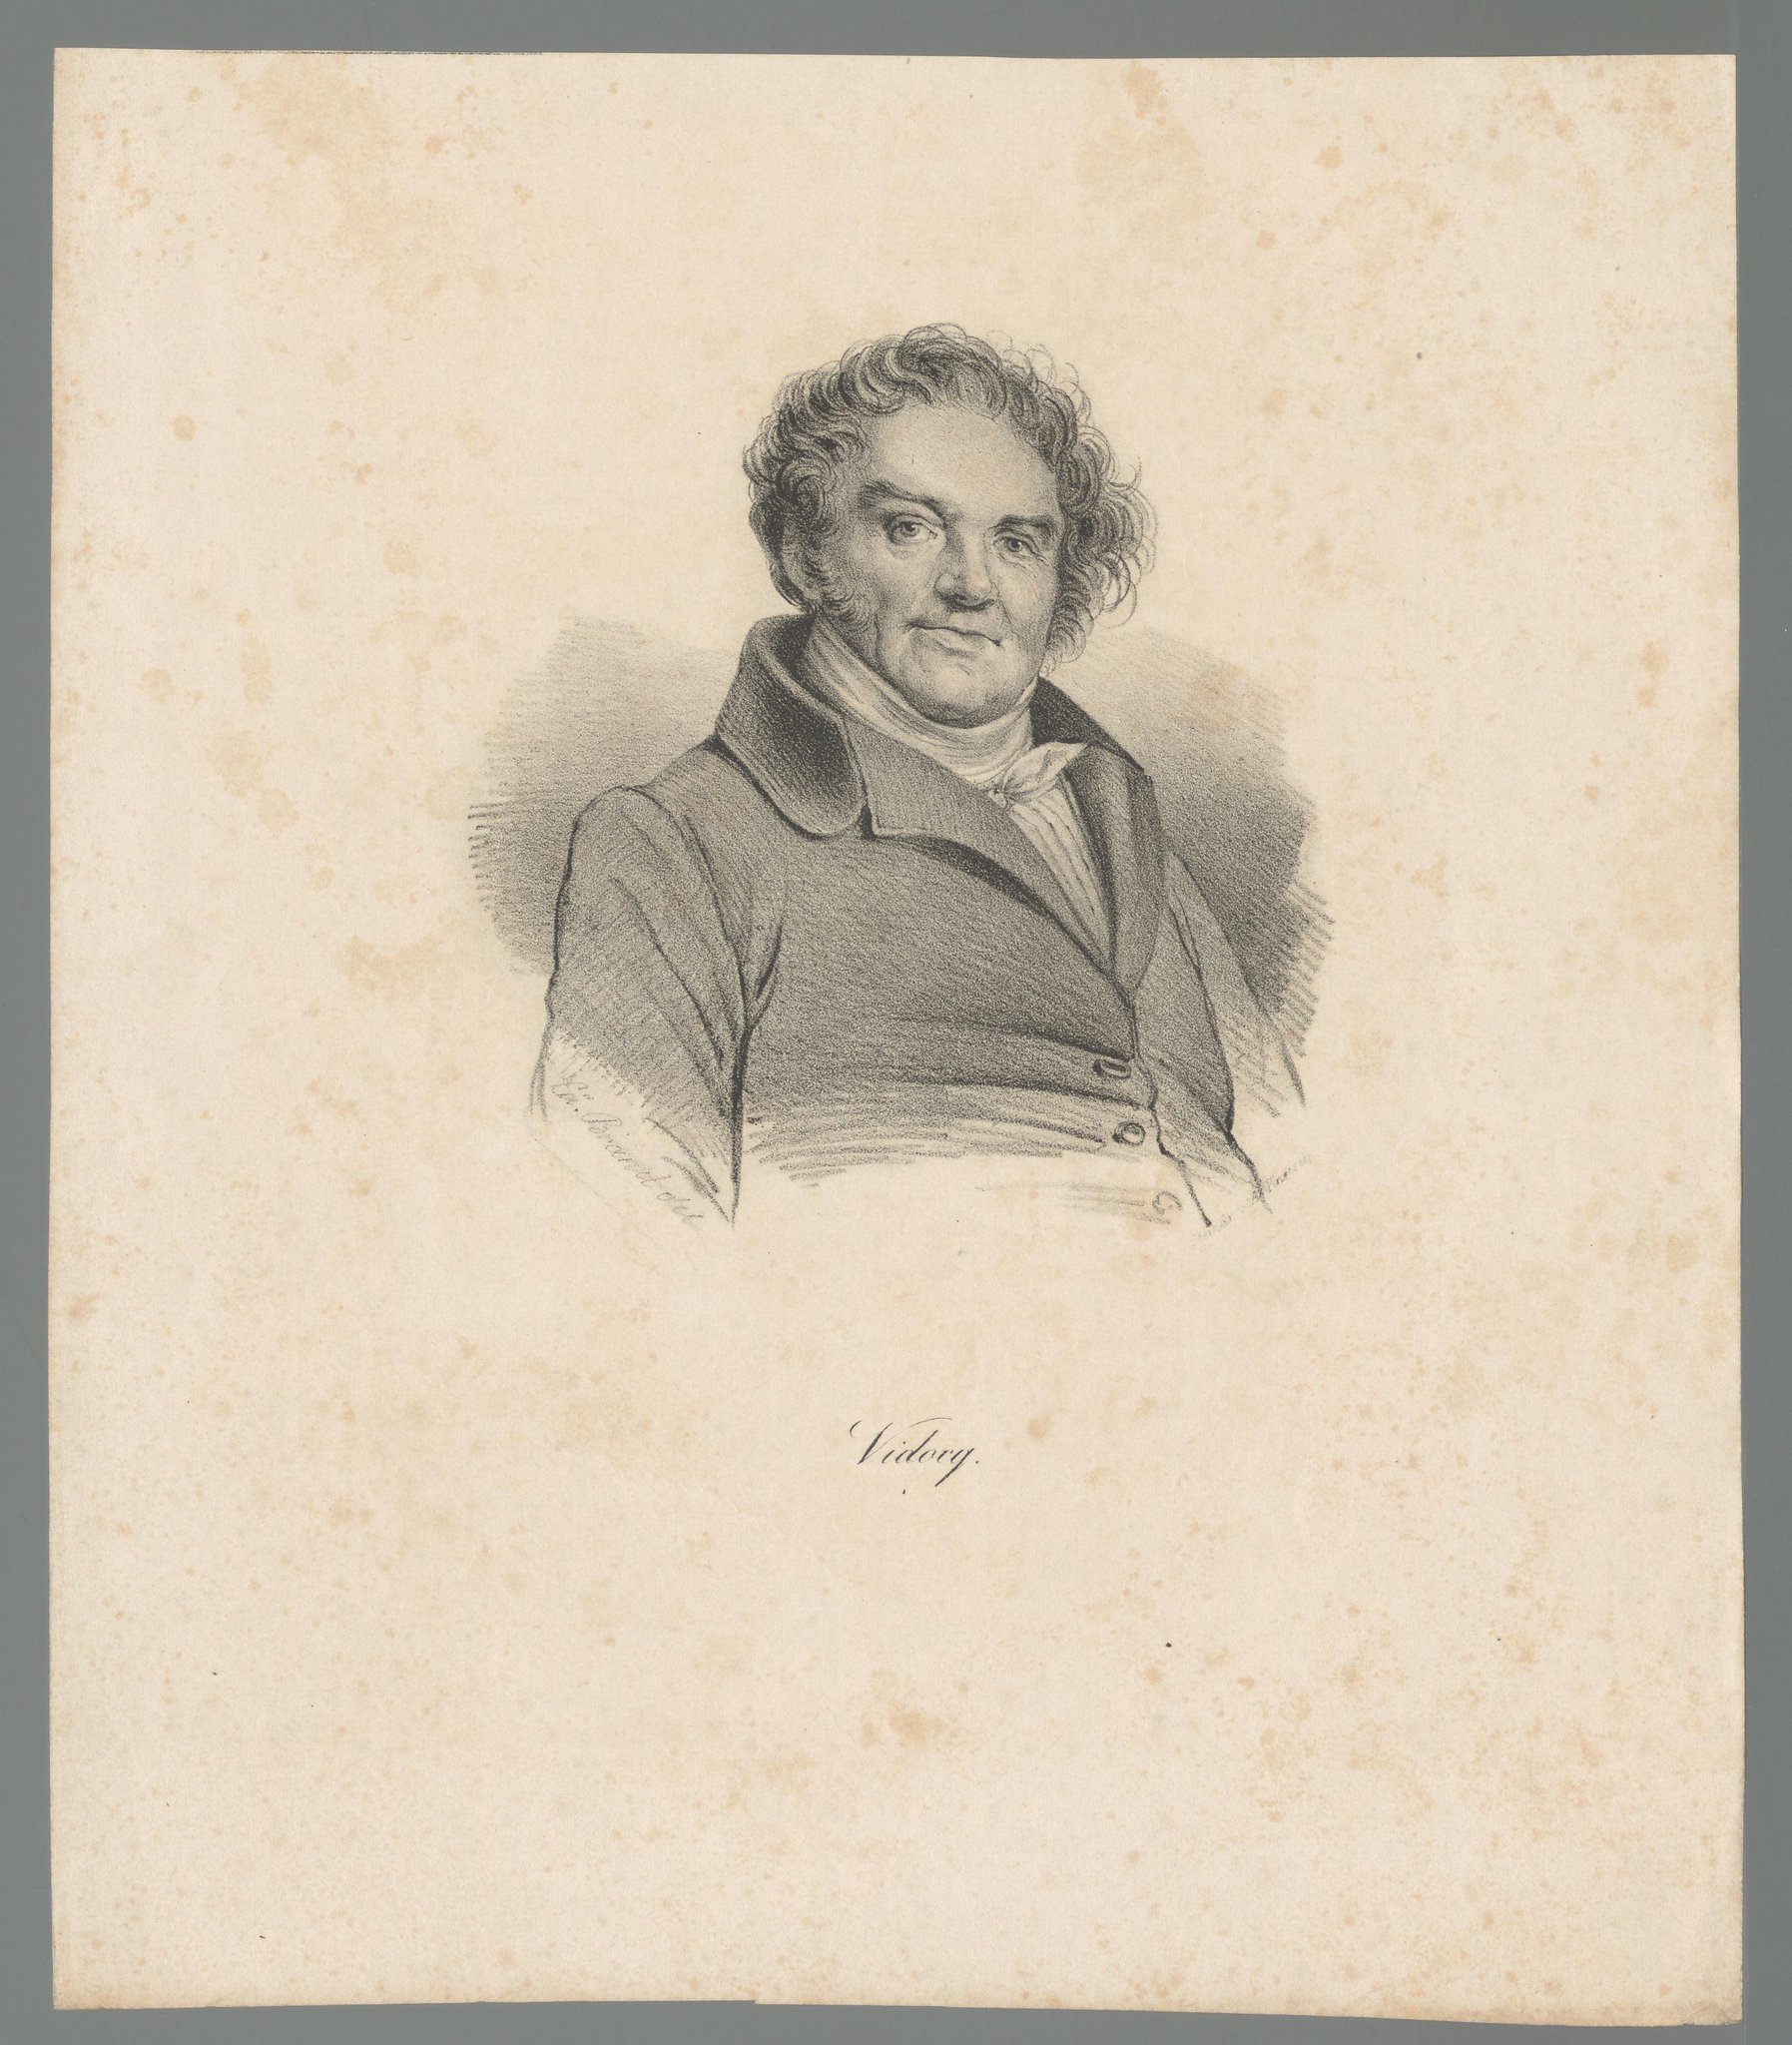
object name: print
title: Vidocq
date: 1825-1850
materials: paper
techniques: lithograph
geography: leipzig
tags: adult man, historical persons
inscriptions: collector's mark: Lugt 2228